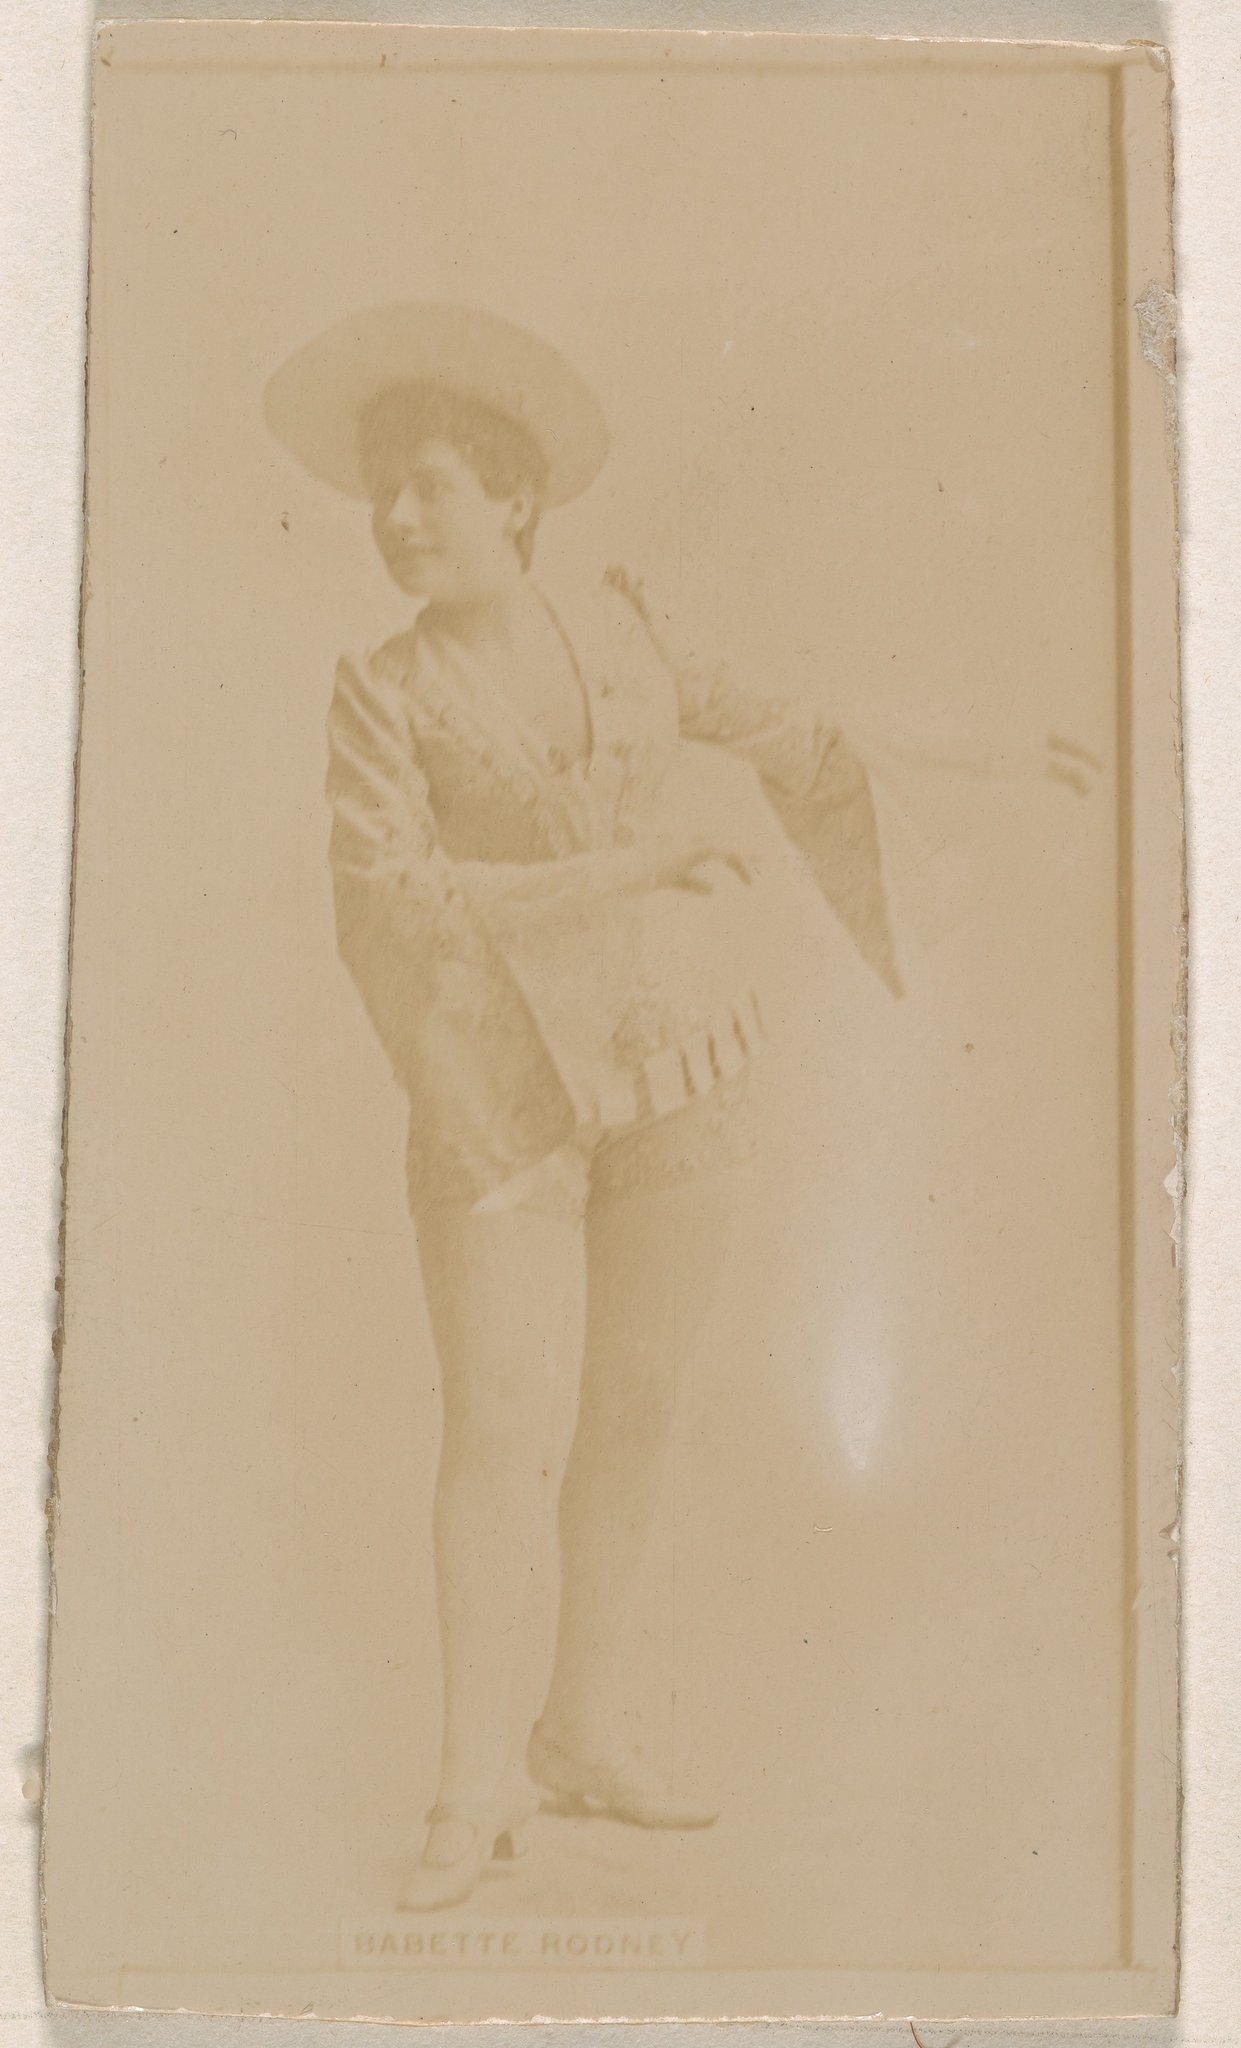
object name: photograph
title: Babette Rodney, from the Actresses series (N245) issued by Kinney Brothers to promote Sweet Caporal Cigarettes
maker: kinney brothers tobacco company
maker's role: publisher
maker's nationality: american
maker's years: 1869-2011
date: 1890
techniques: albumen silver print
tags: portraits,women,actresses